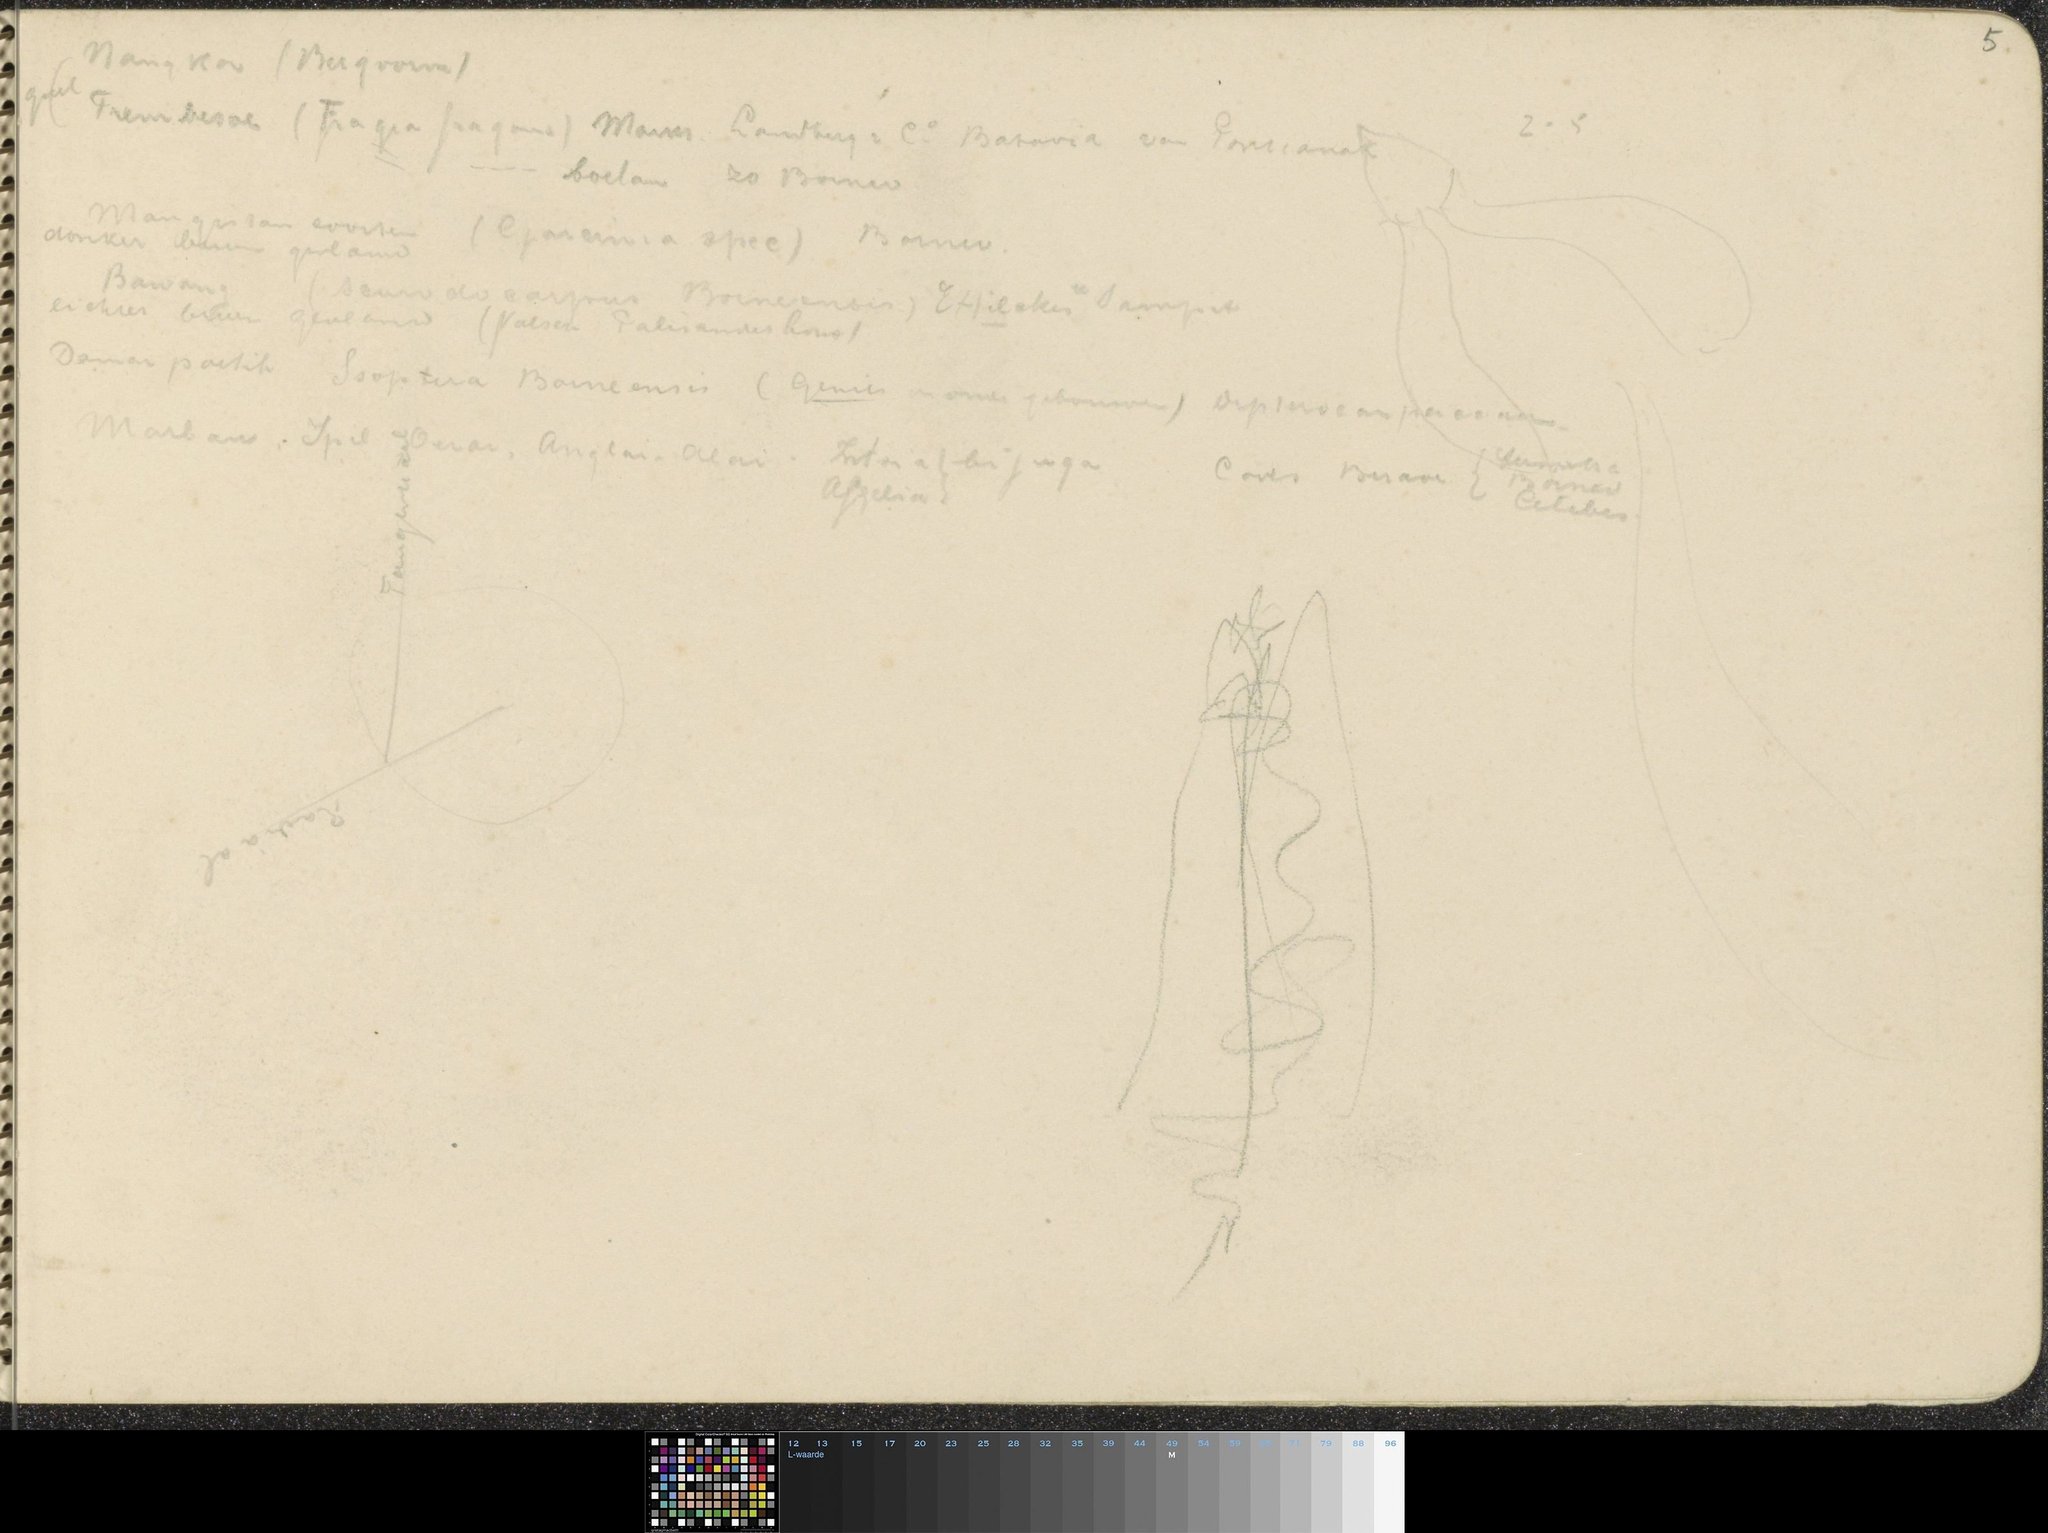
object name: sketchbook leaf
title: Studies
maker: carel adolph lion cachet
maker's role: draughtsman, print maker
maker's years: 1864-1945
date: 1934-1943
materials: paper, pencil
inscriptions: annotation: ‘[...]’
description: Blad 5 recto uit een schetsboek met 19 bladen.